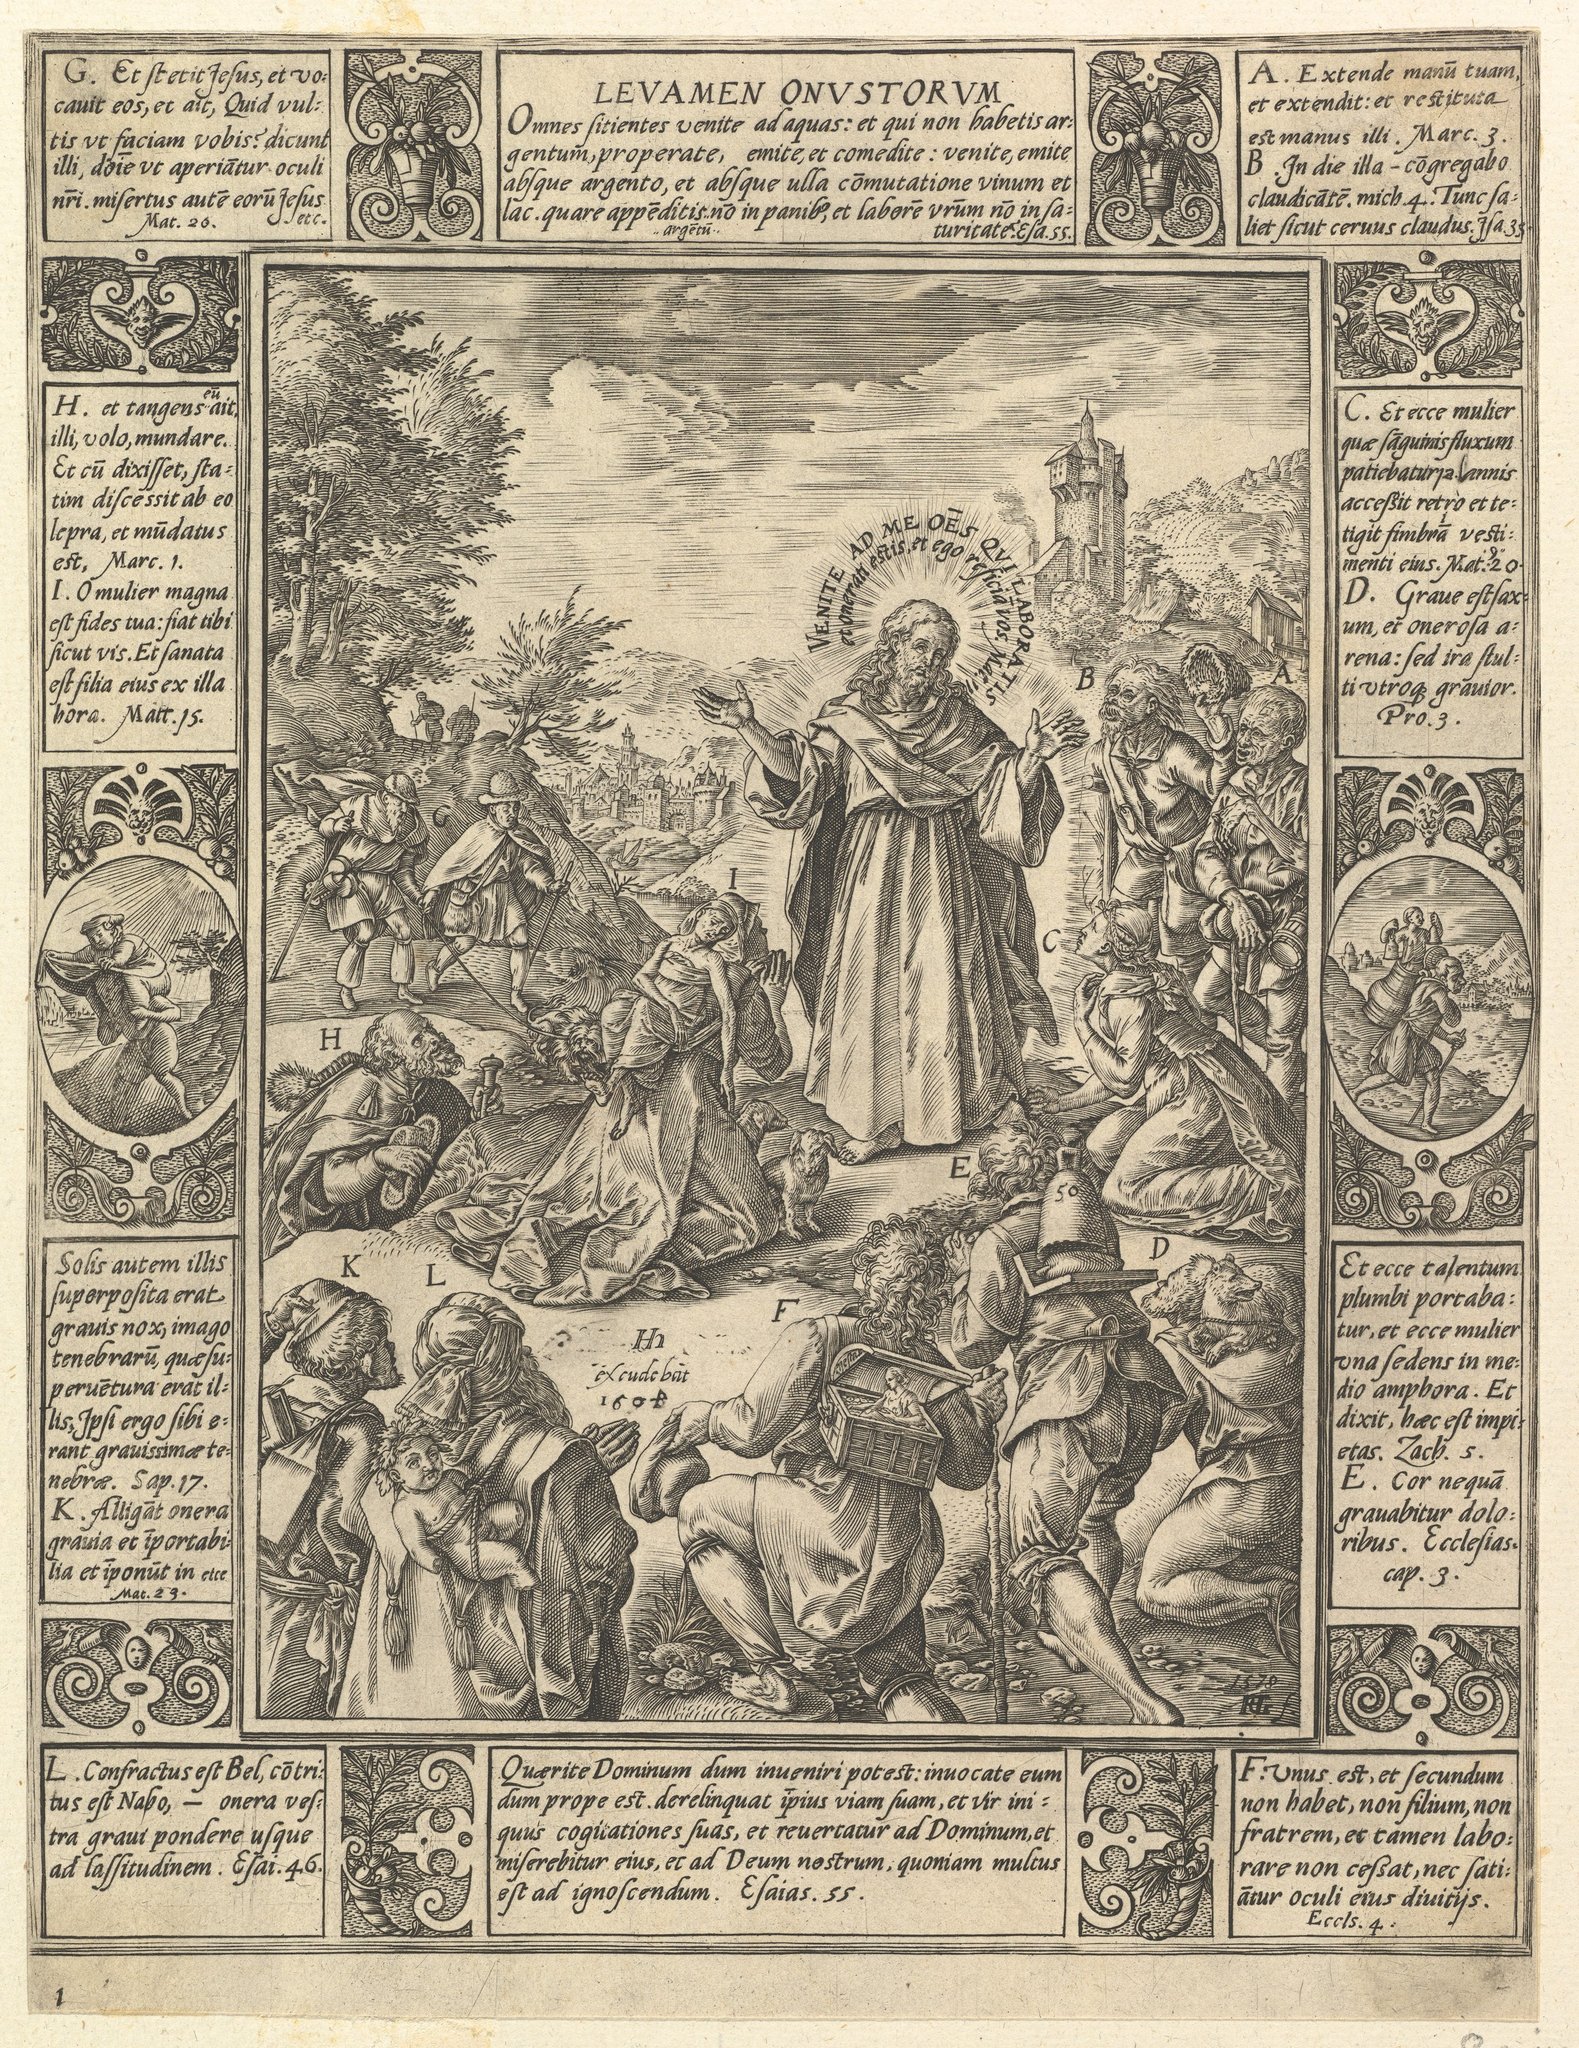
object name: print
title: Levamen Onostrorum, from "Allegories of the Christian Faith, from Christian and Profane Allegories"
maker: hendrick goltzius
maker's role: artist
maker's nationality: netherlandish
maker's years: 1558-1617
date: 1604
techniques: engraving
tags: animals,soldiers,men,women,christ